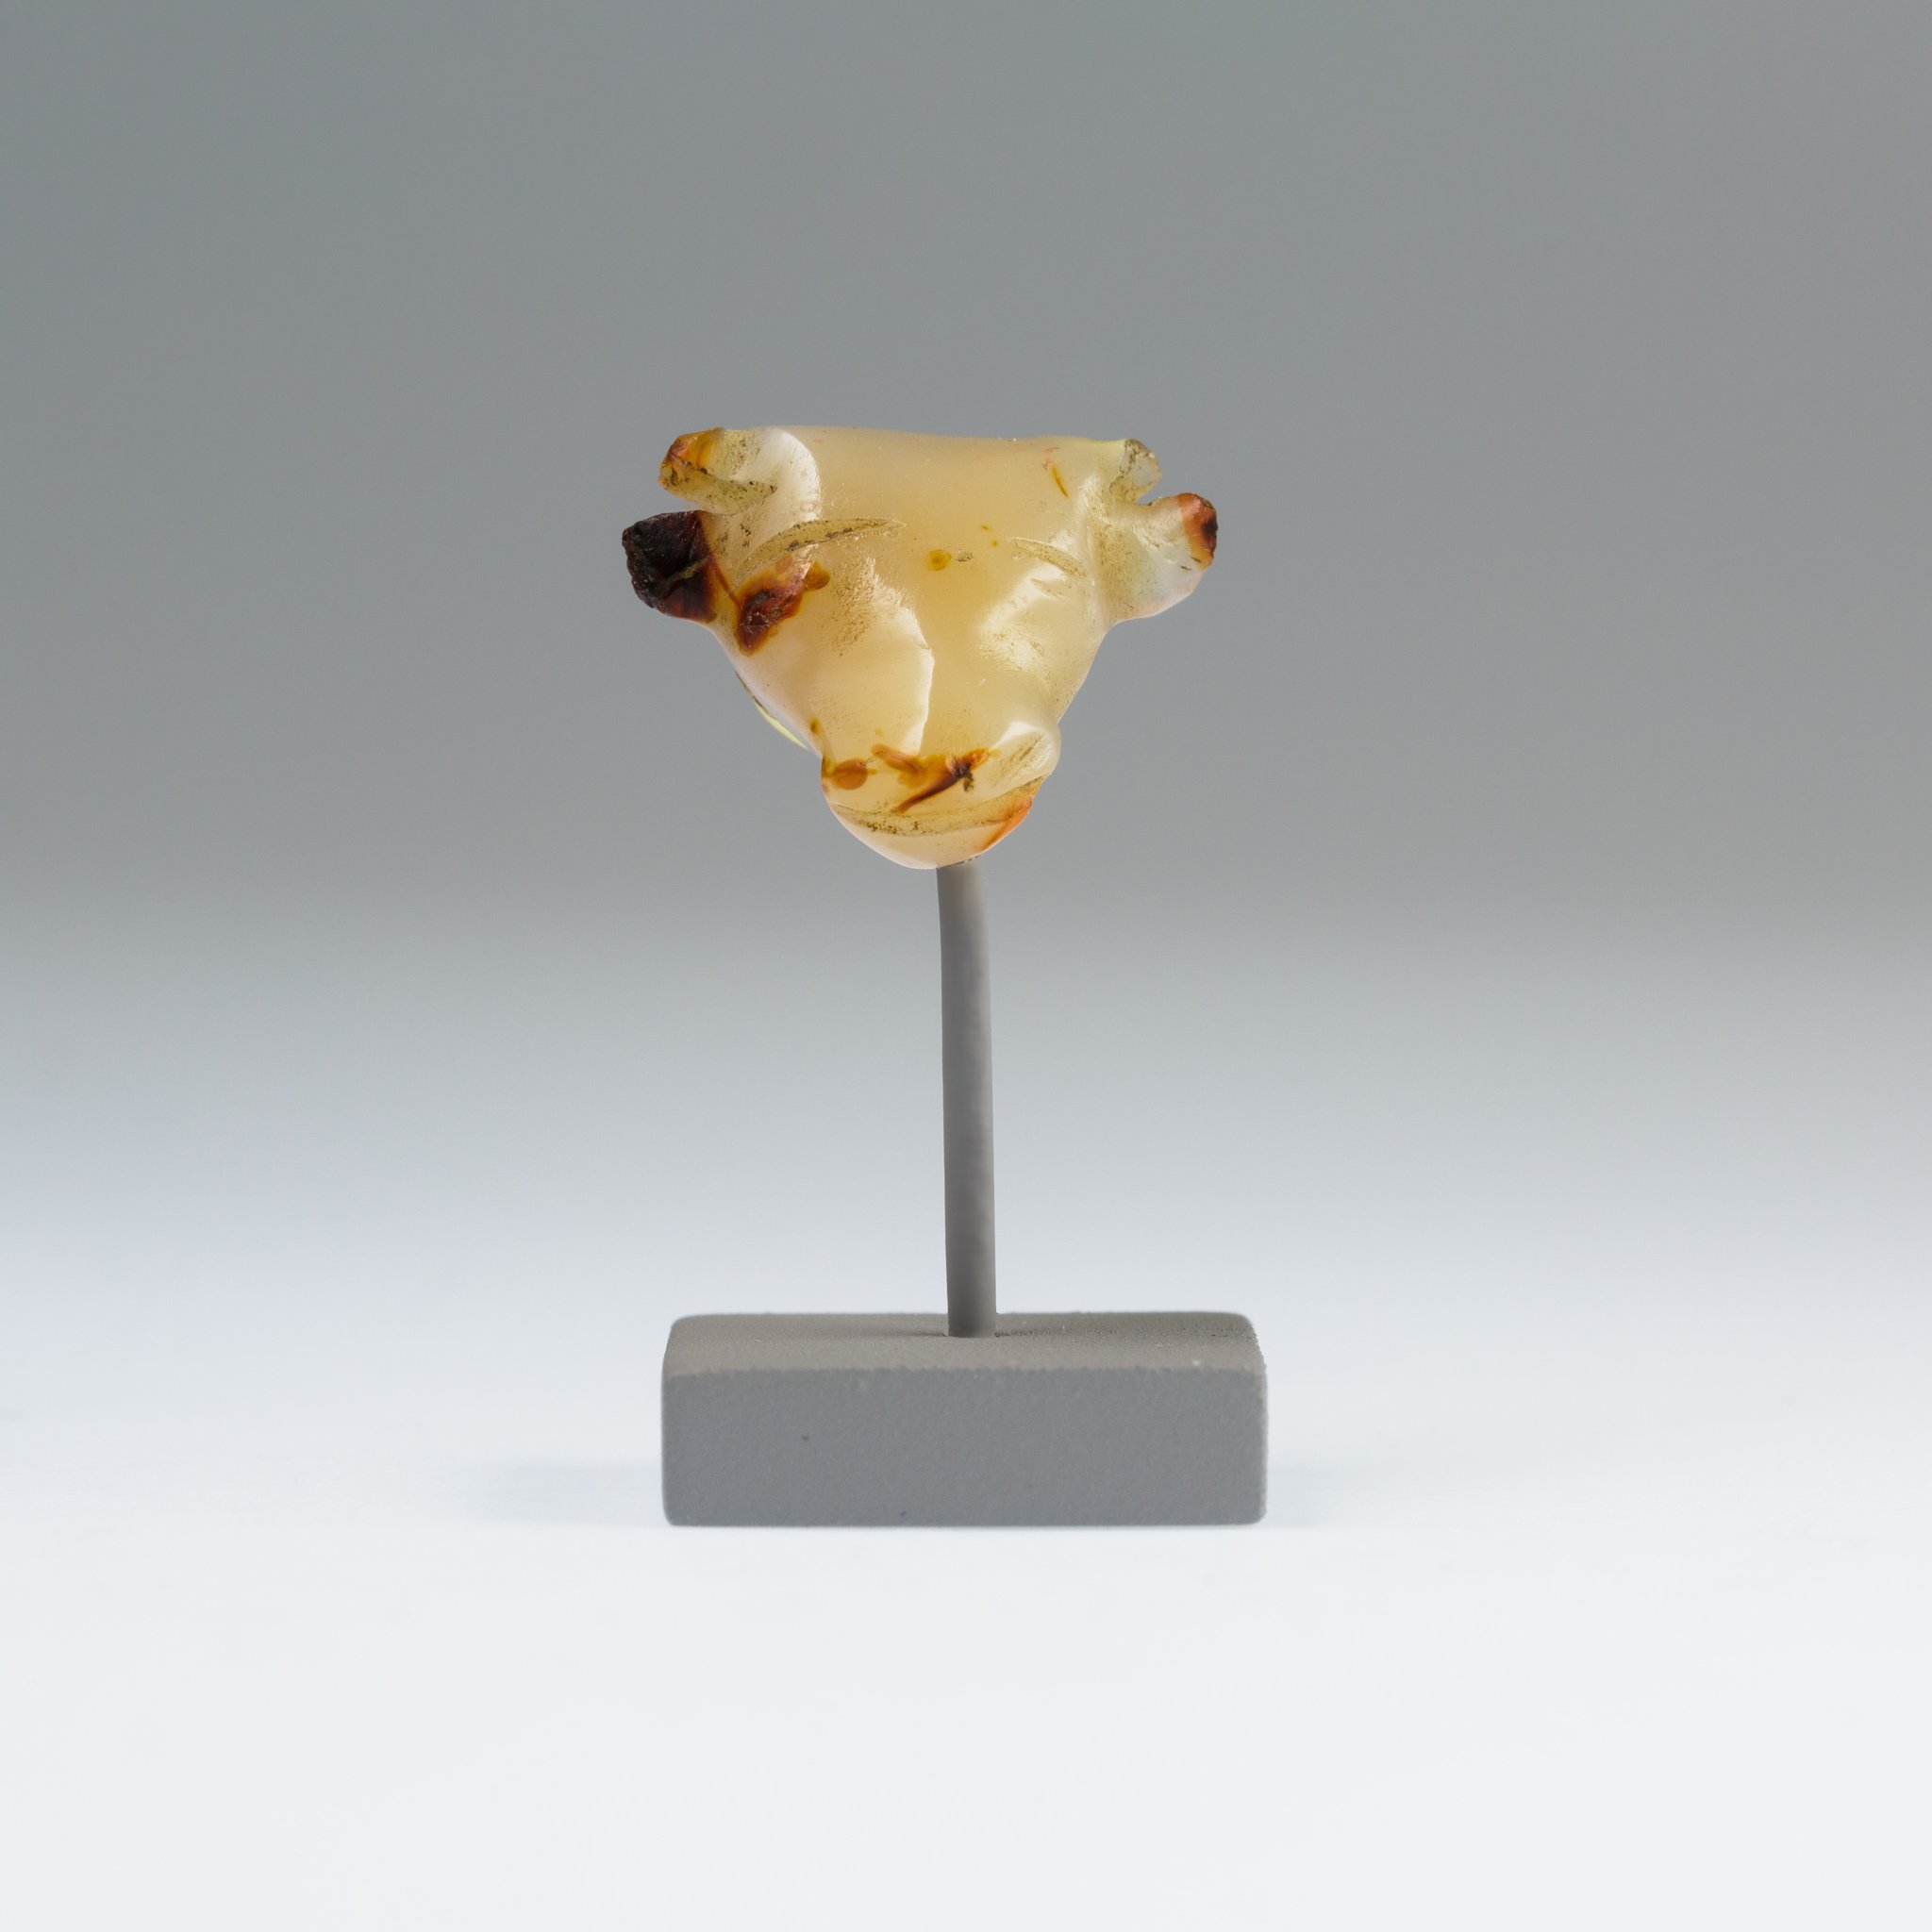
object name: amulet, cow head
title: Calf's Head Amulet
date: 664-332 BCE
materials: stone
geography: egypt